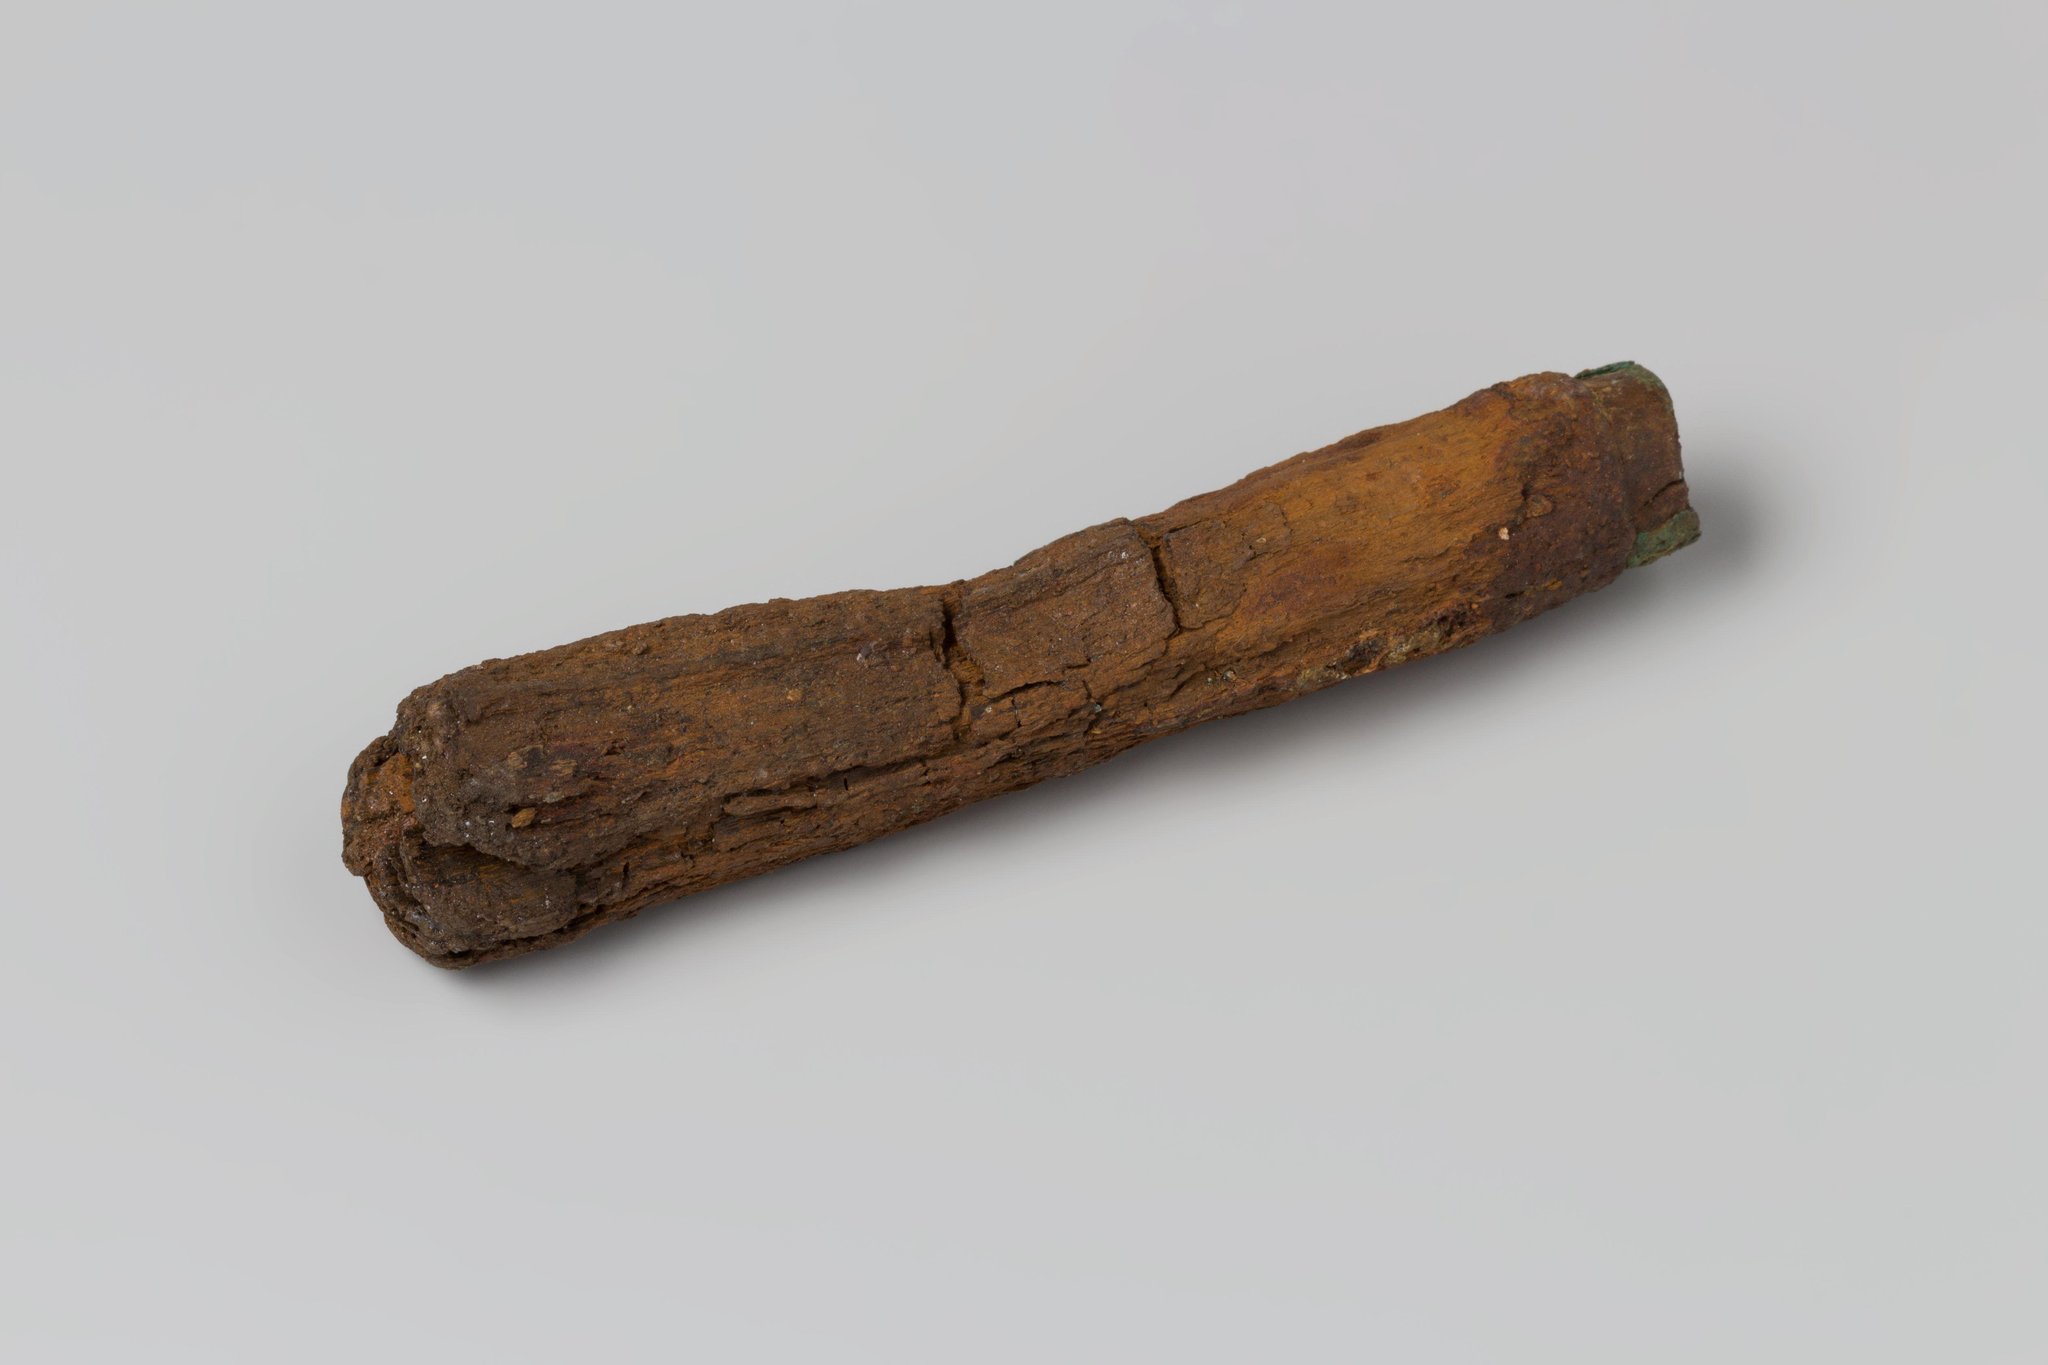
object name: knife handle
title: Messenheft uit het wrak van de Oost-Indiëvaarder Hollandia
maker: Anonymous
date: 1700-1743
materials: wood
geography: netherlands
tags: verenigde oostindische compagnie, hollandia (schip), annet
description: Knife, handle, cylindrical: tapering; id. NG 1979-403H, eroded.